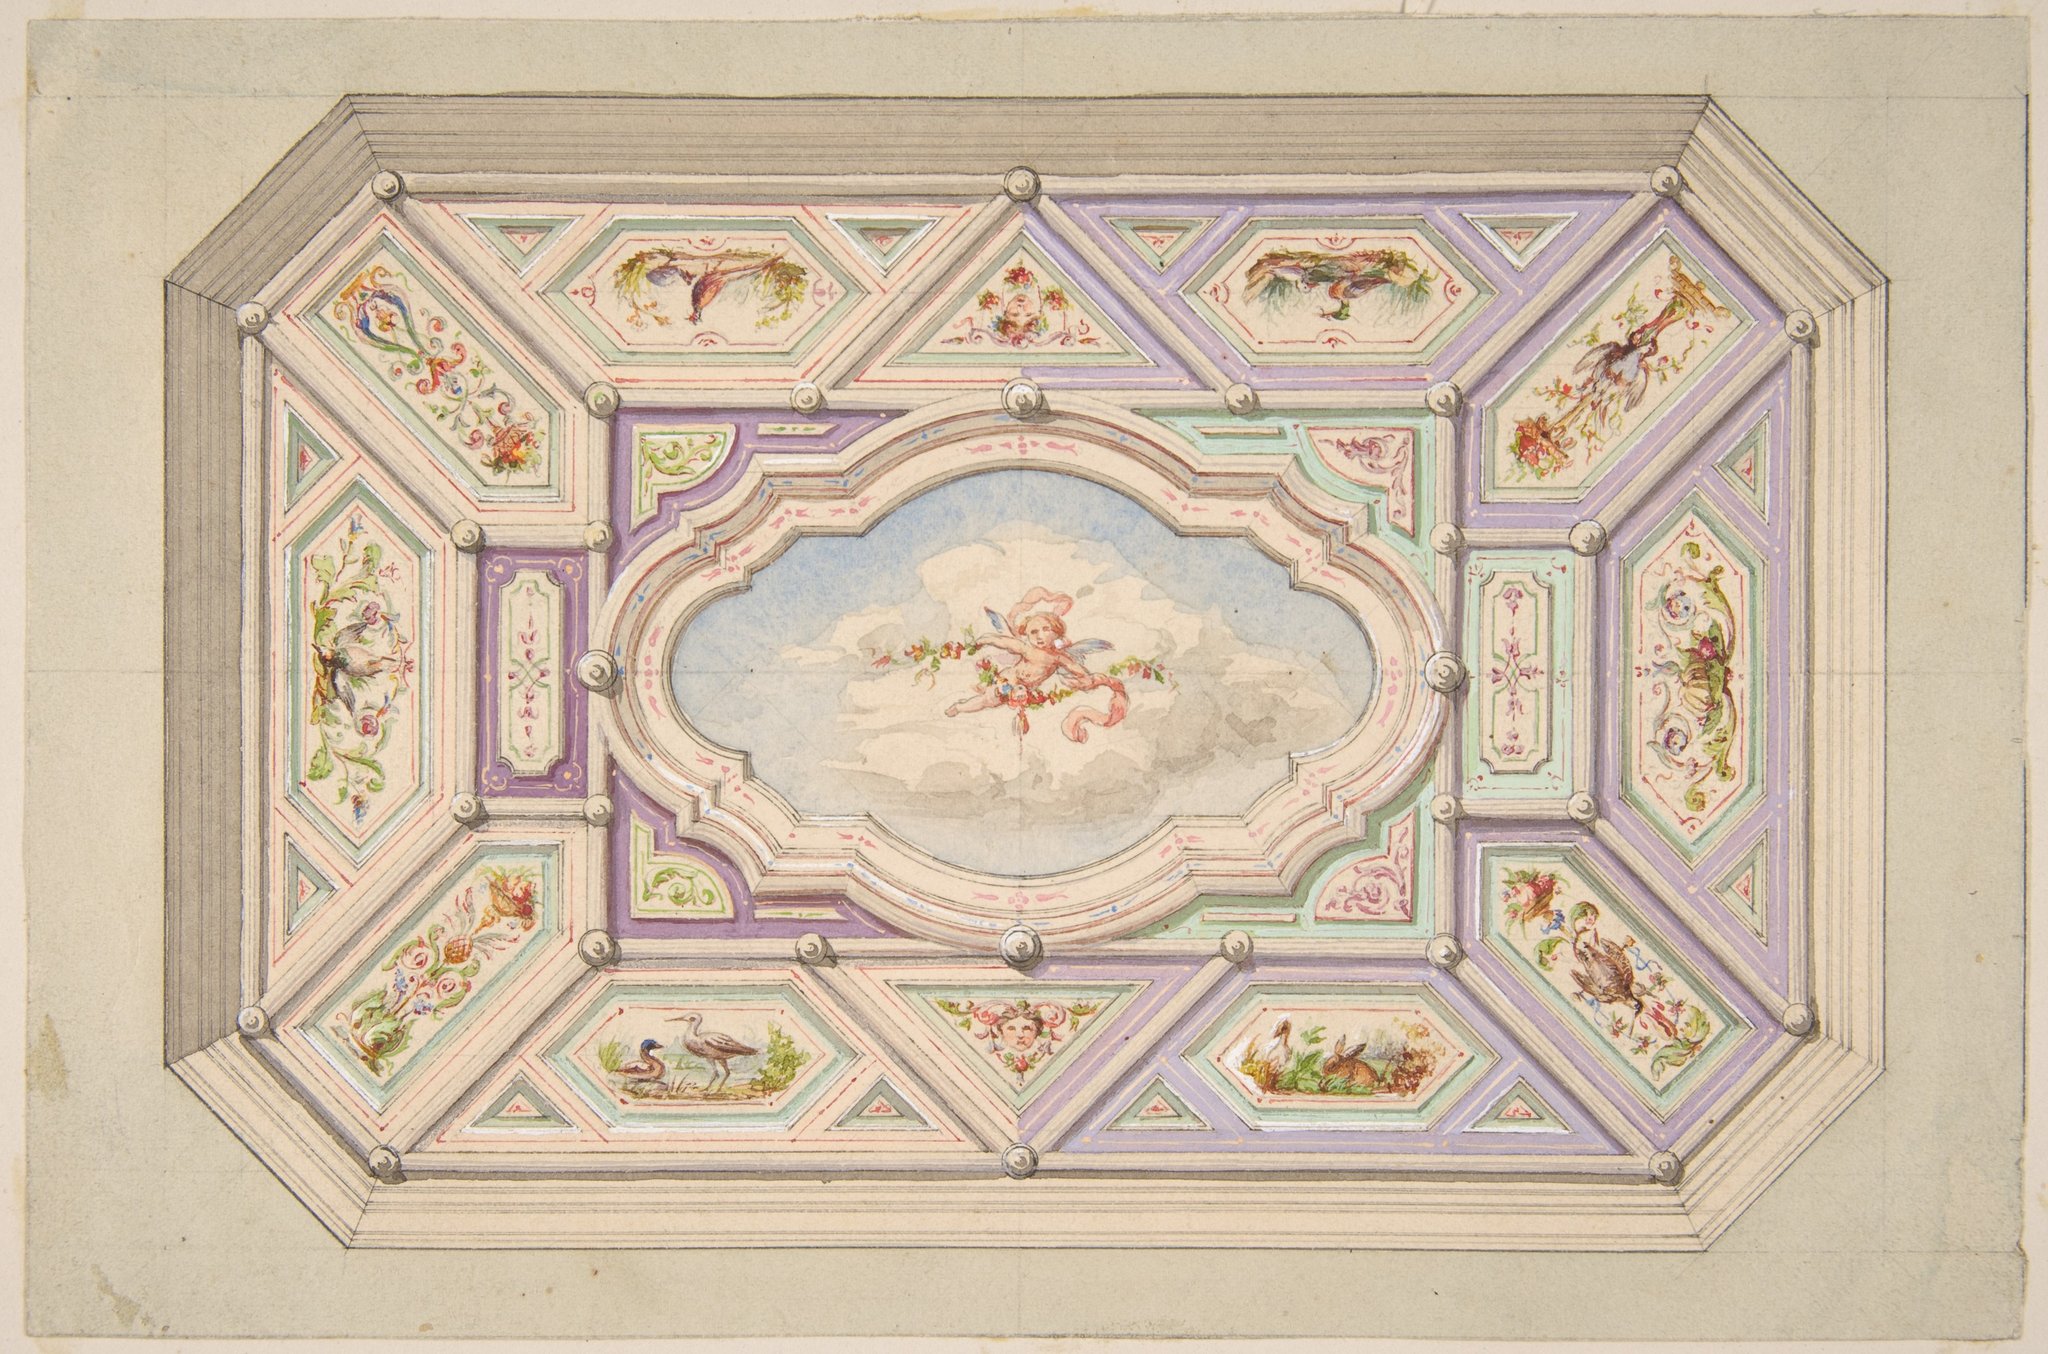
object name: drawing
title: Design for a ceiling with a putto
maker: jules-edmond-charles lachaise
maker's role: artist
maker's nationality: french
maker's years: 1897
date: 1851-1900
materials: gouache, graphite, ink, watercolor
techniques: pen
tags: birds,architecture,putti